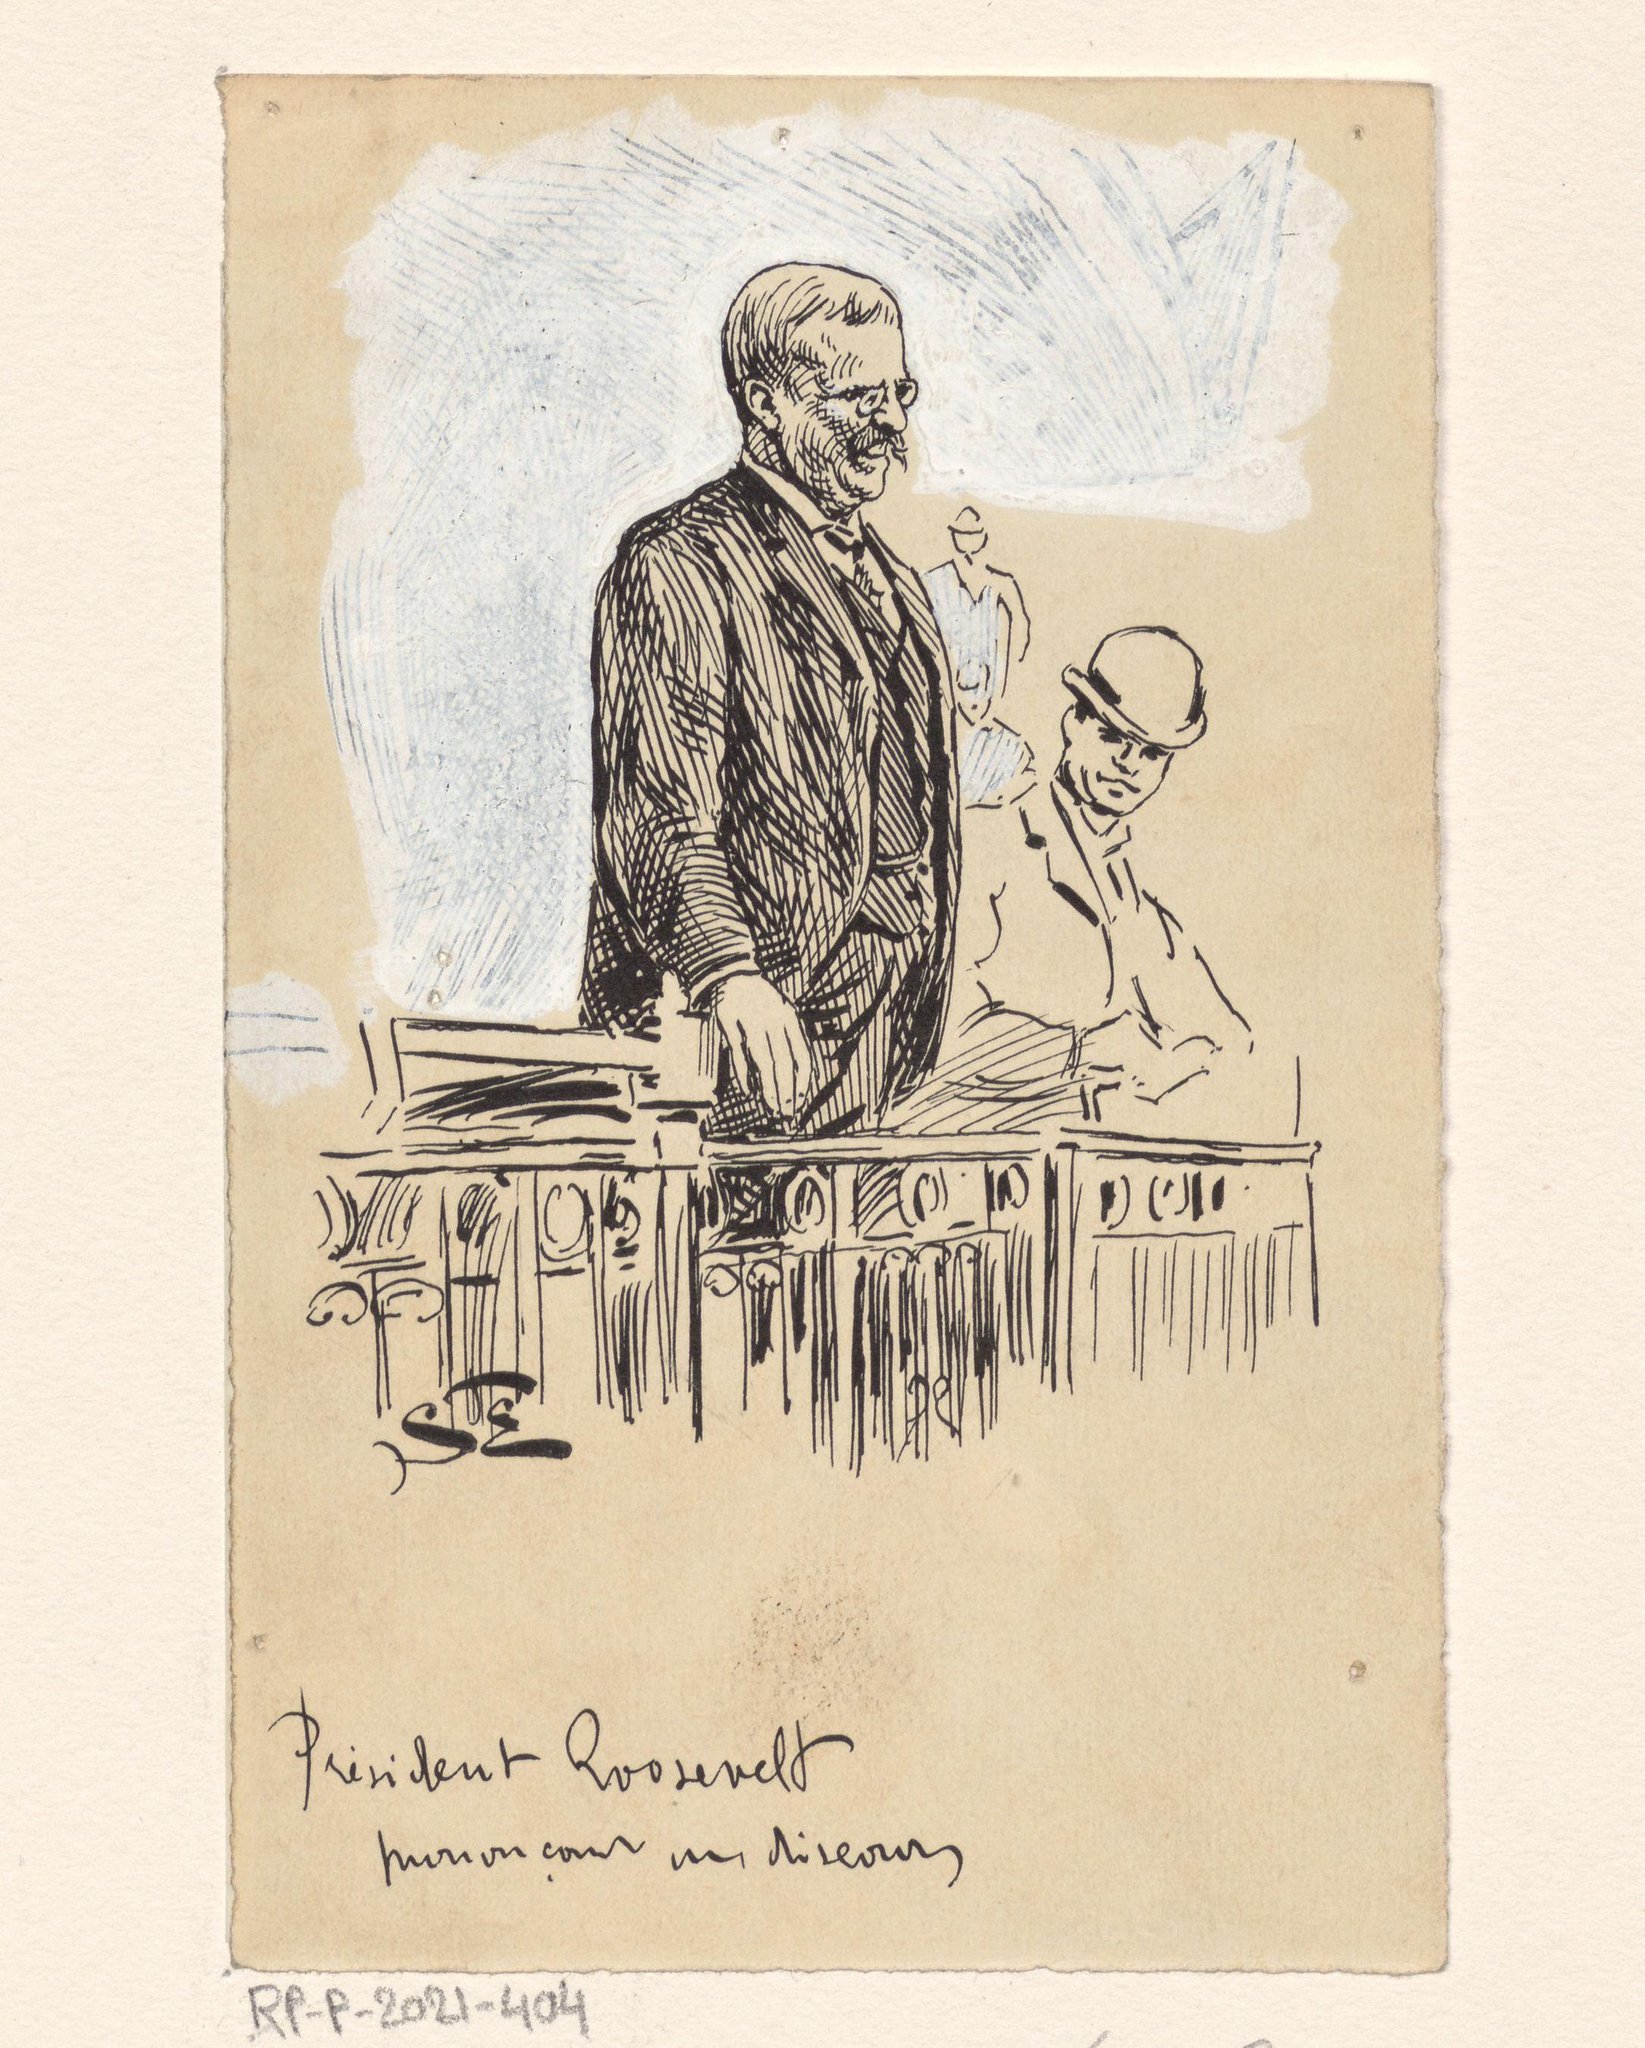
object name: drawing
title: Portret van Theodore Roosevelt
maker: Anonymous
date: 1901-1949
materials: paint, ink, paper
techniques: brush, pen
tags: new york (city), politician, historical persons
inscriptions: signature: ‘STE’